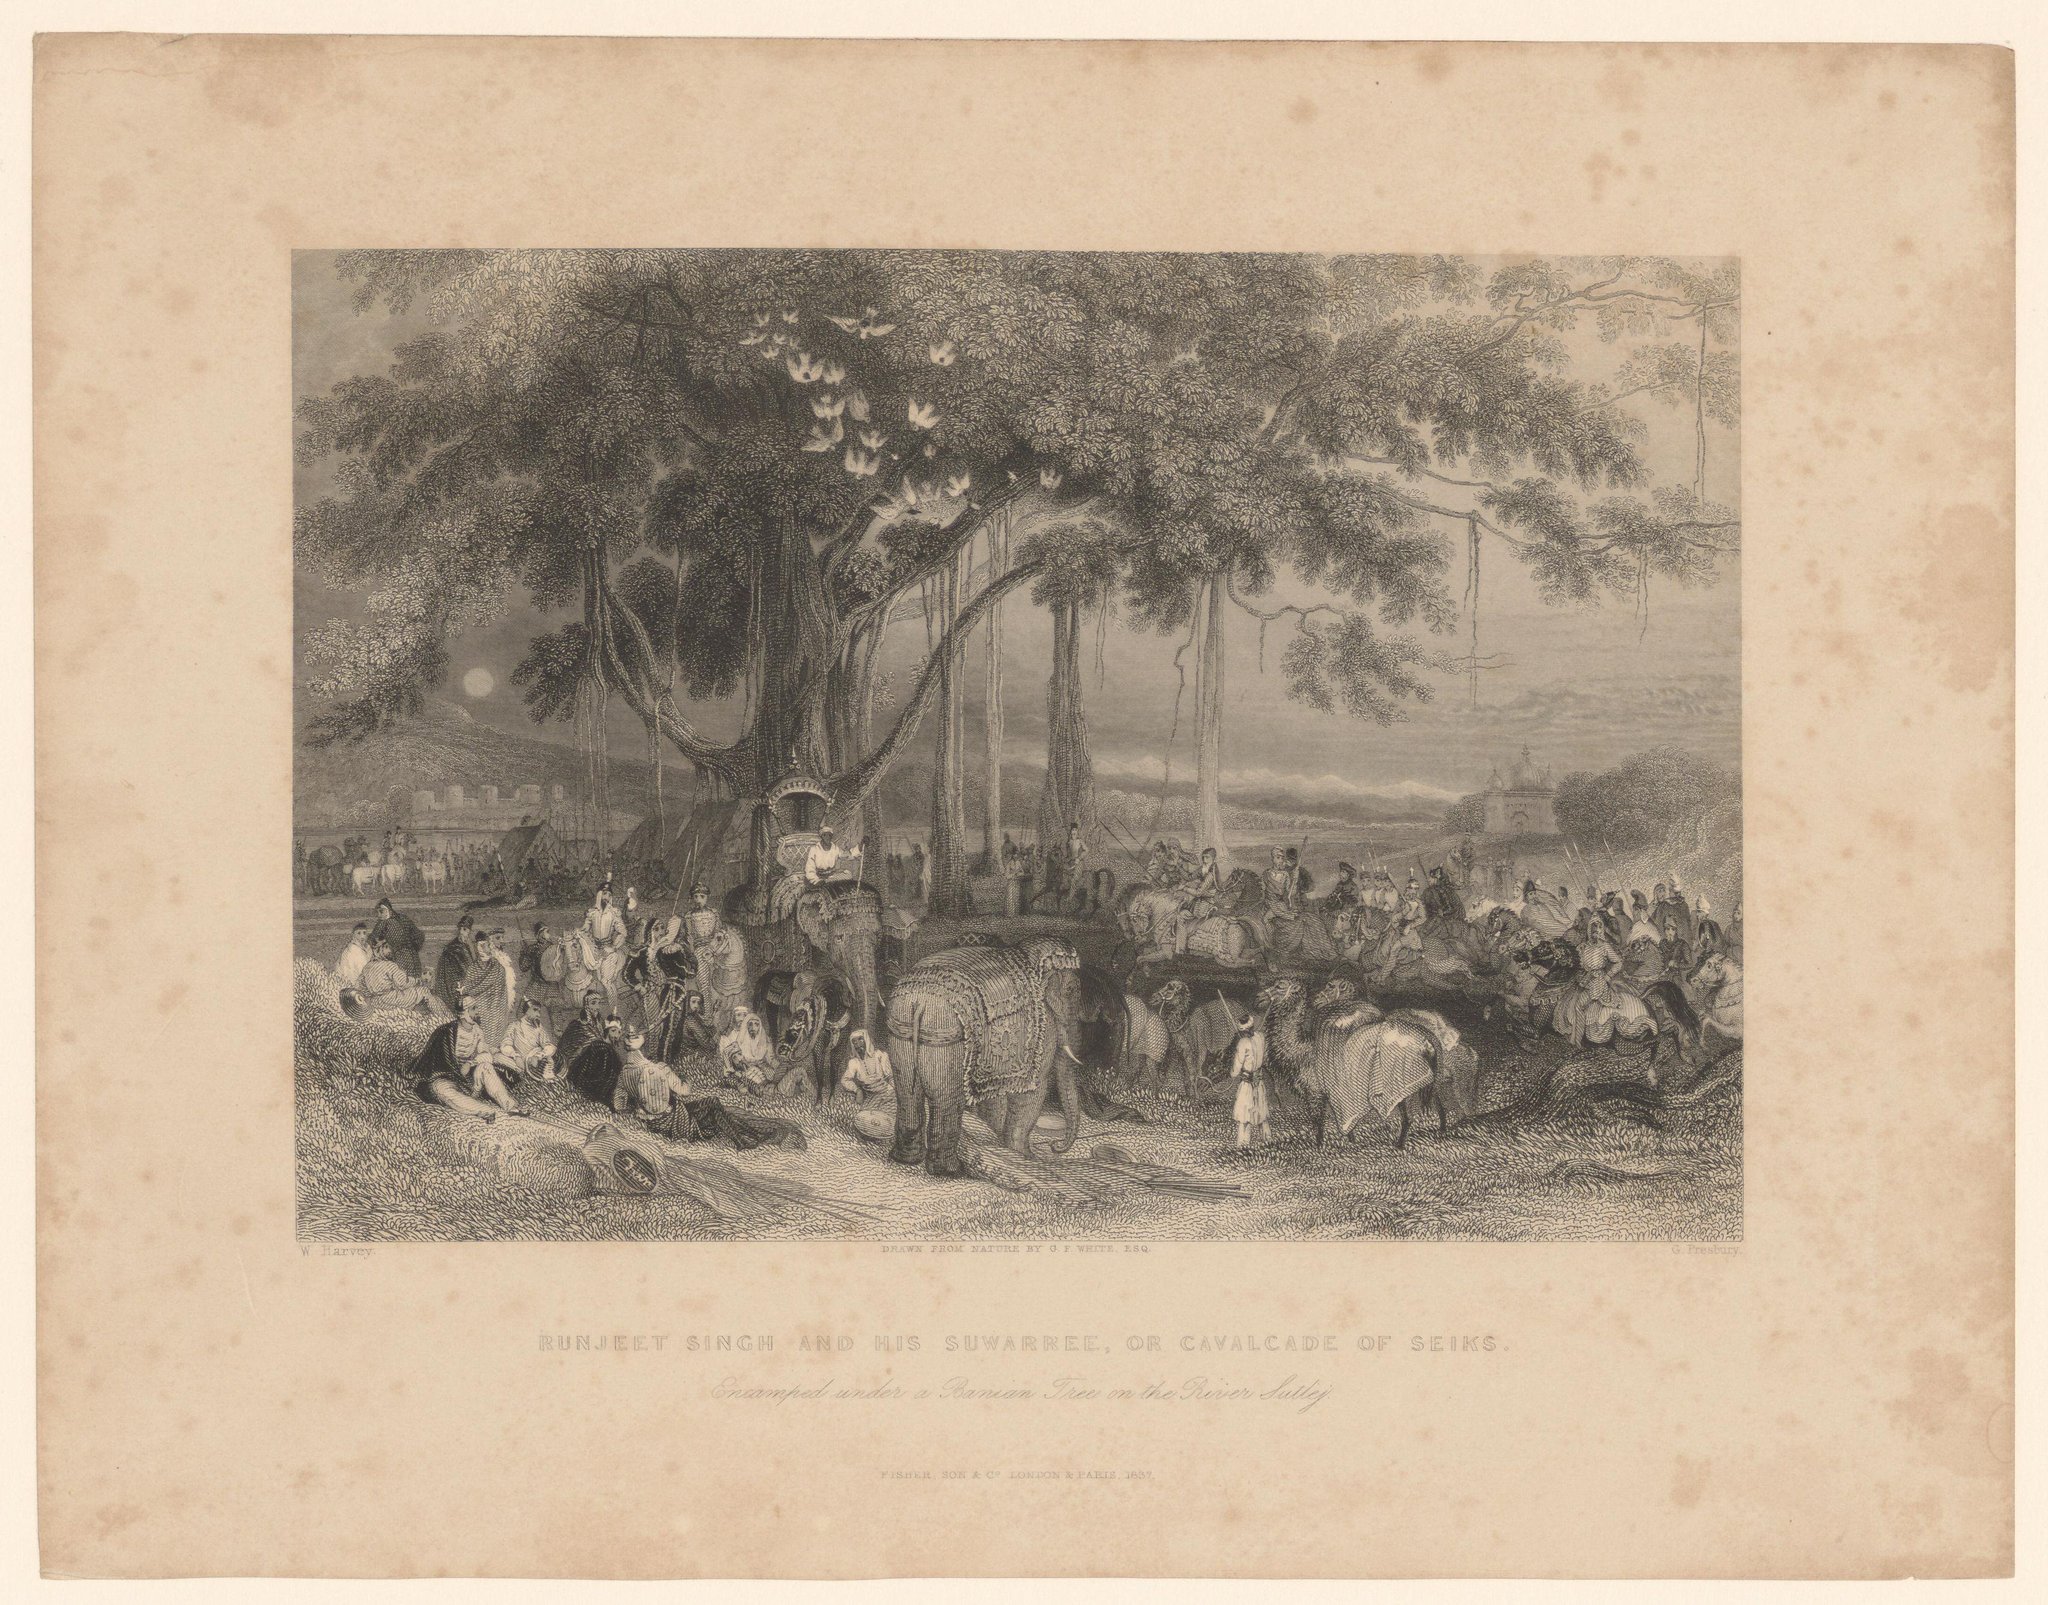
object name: print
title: Runjeet Singh and his Suwarree, or Cavalcade of Seiks / Encamped under a Banian Tree on the River Sutley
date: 1837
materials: paper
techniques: engraving, etching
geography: paris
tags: politician, historical persons, meeting, assembling of military forces; mobilization, troop concentration, etc.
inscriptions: collector's mark: Lugt 2228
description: Prent gebruikt in: White, George Francis. Views in India, chiefly among the Himalaya Mountains. Londen en Parijs: Fisher, Son and Co, 1836.